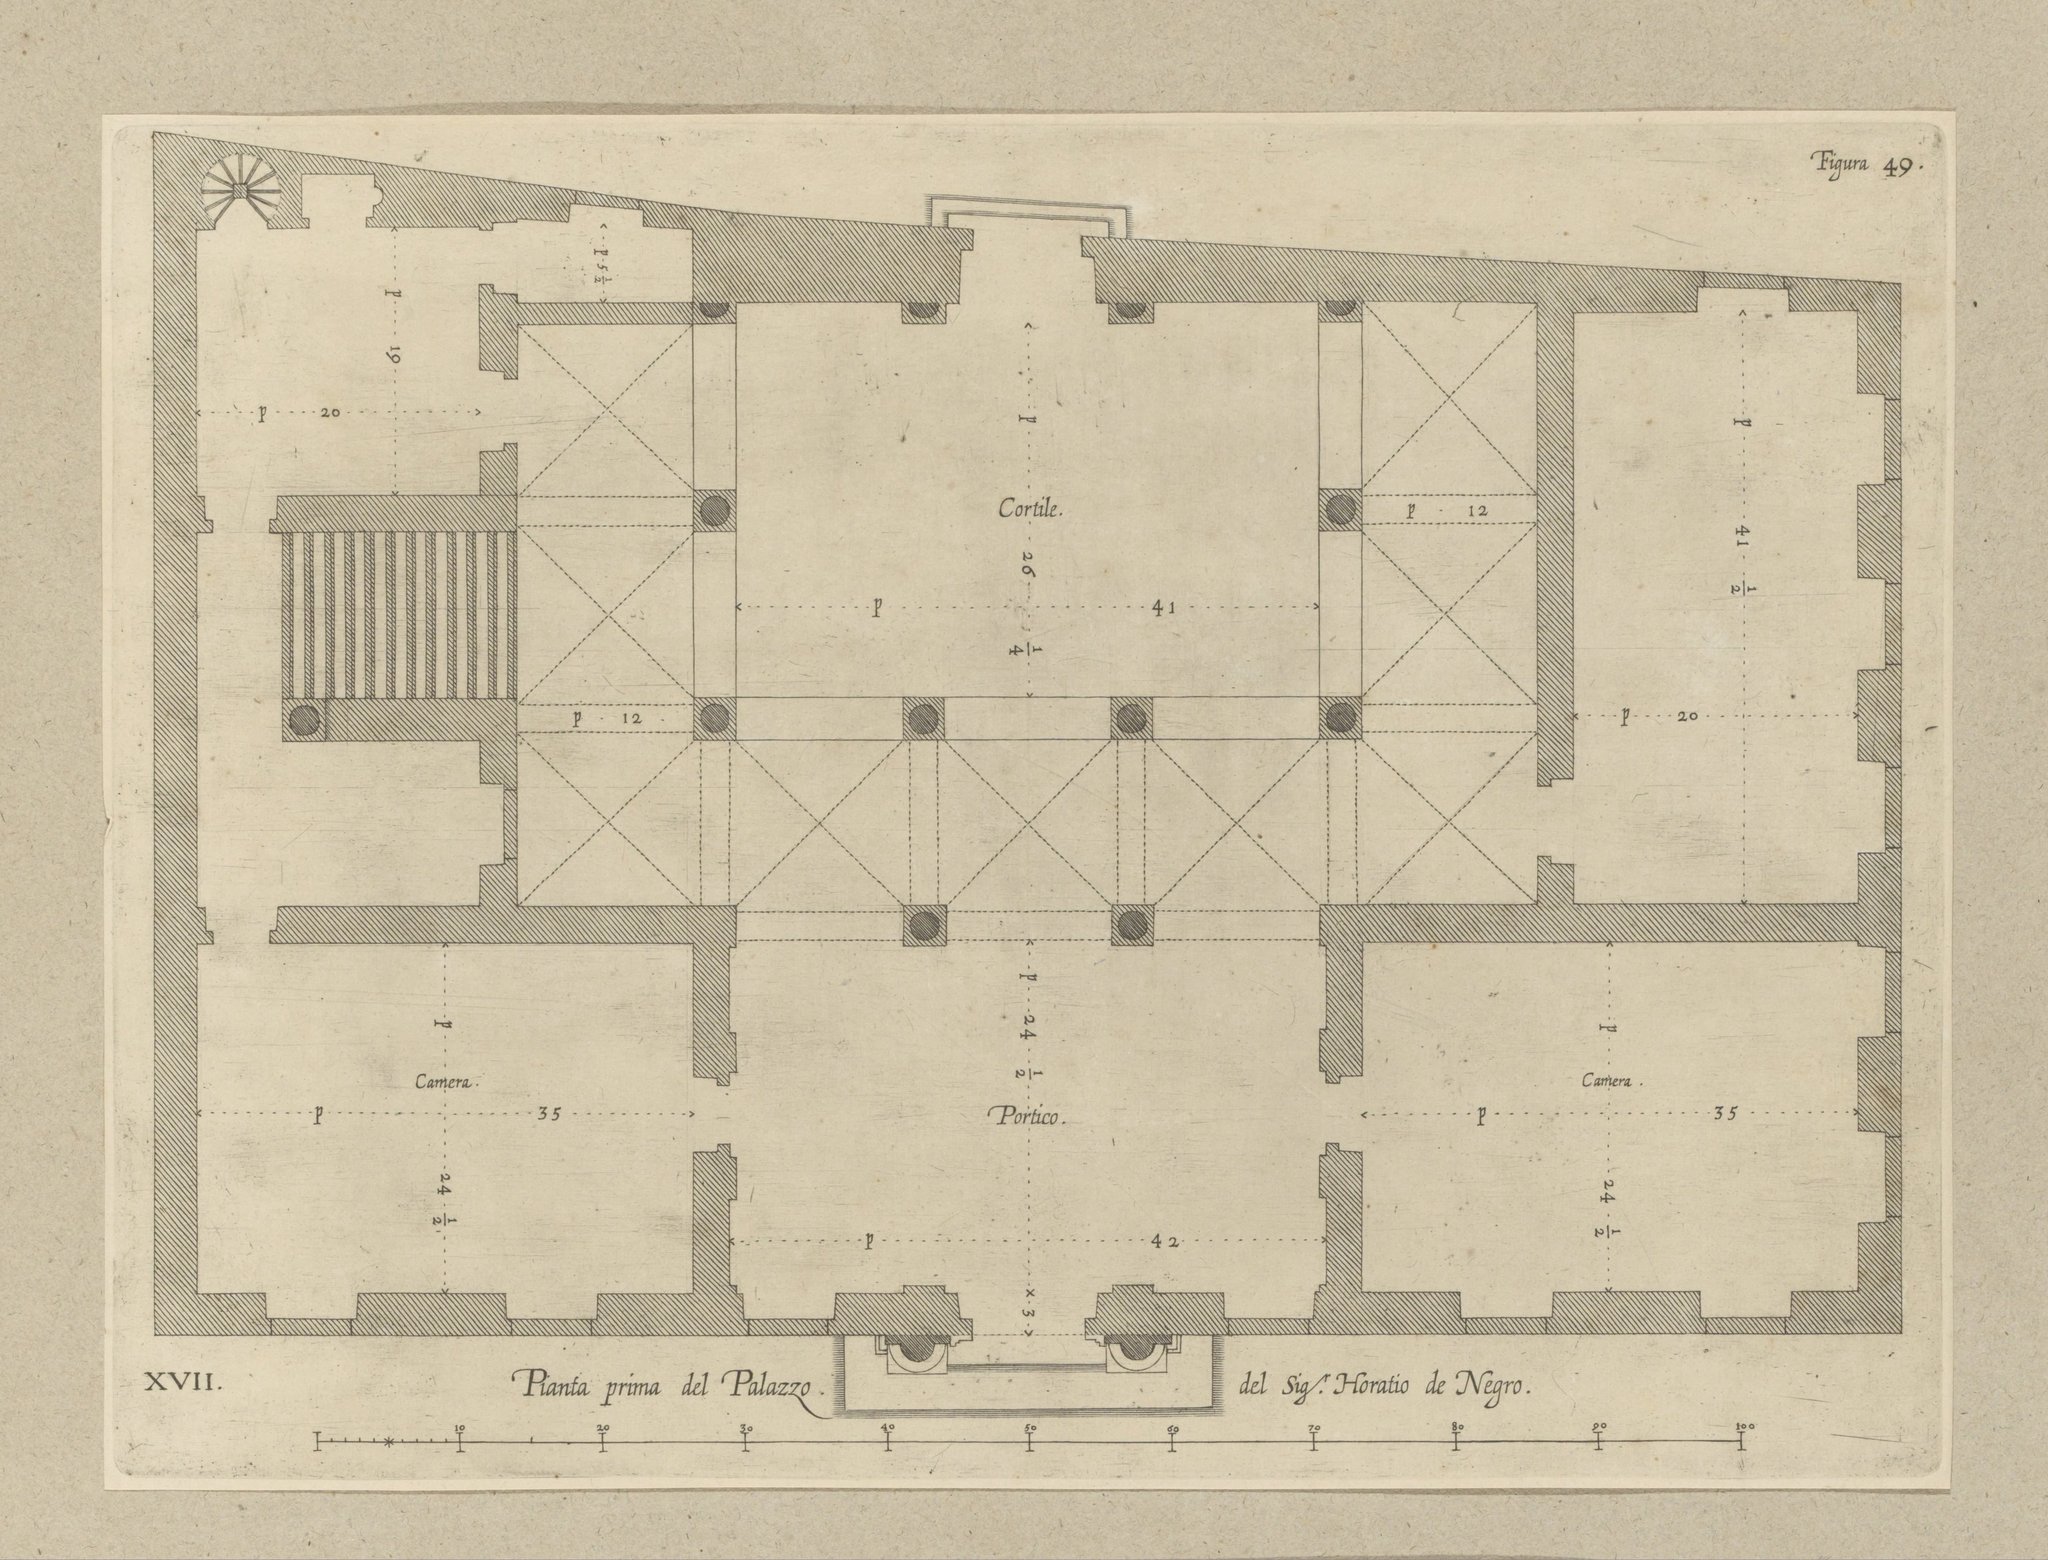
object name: album leaf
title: Plattegrond van de begane grond van het Palazzo Ambrogio Di Negro te Genua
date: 1622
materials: paper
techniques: engraving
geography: antwerp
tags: hôtel, i.e. small palace in city - aa - civic architecture: inside, plan ~ architecture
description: Deze prent maakt deel uit van een album.